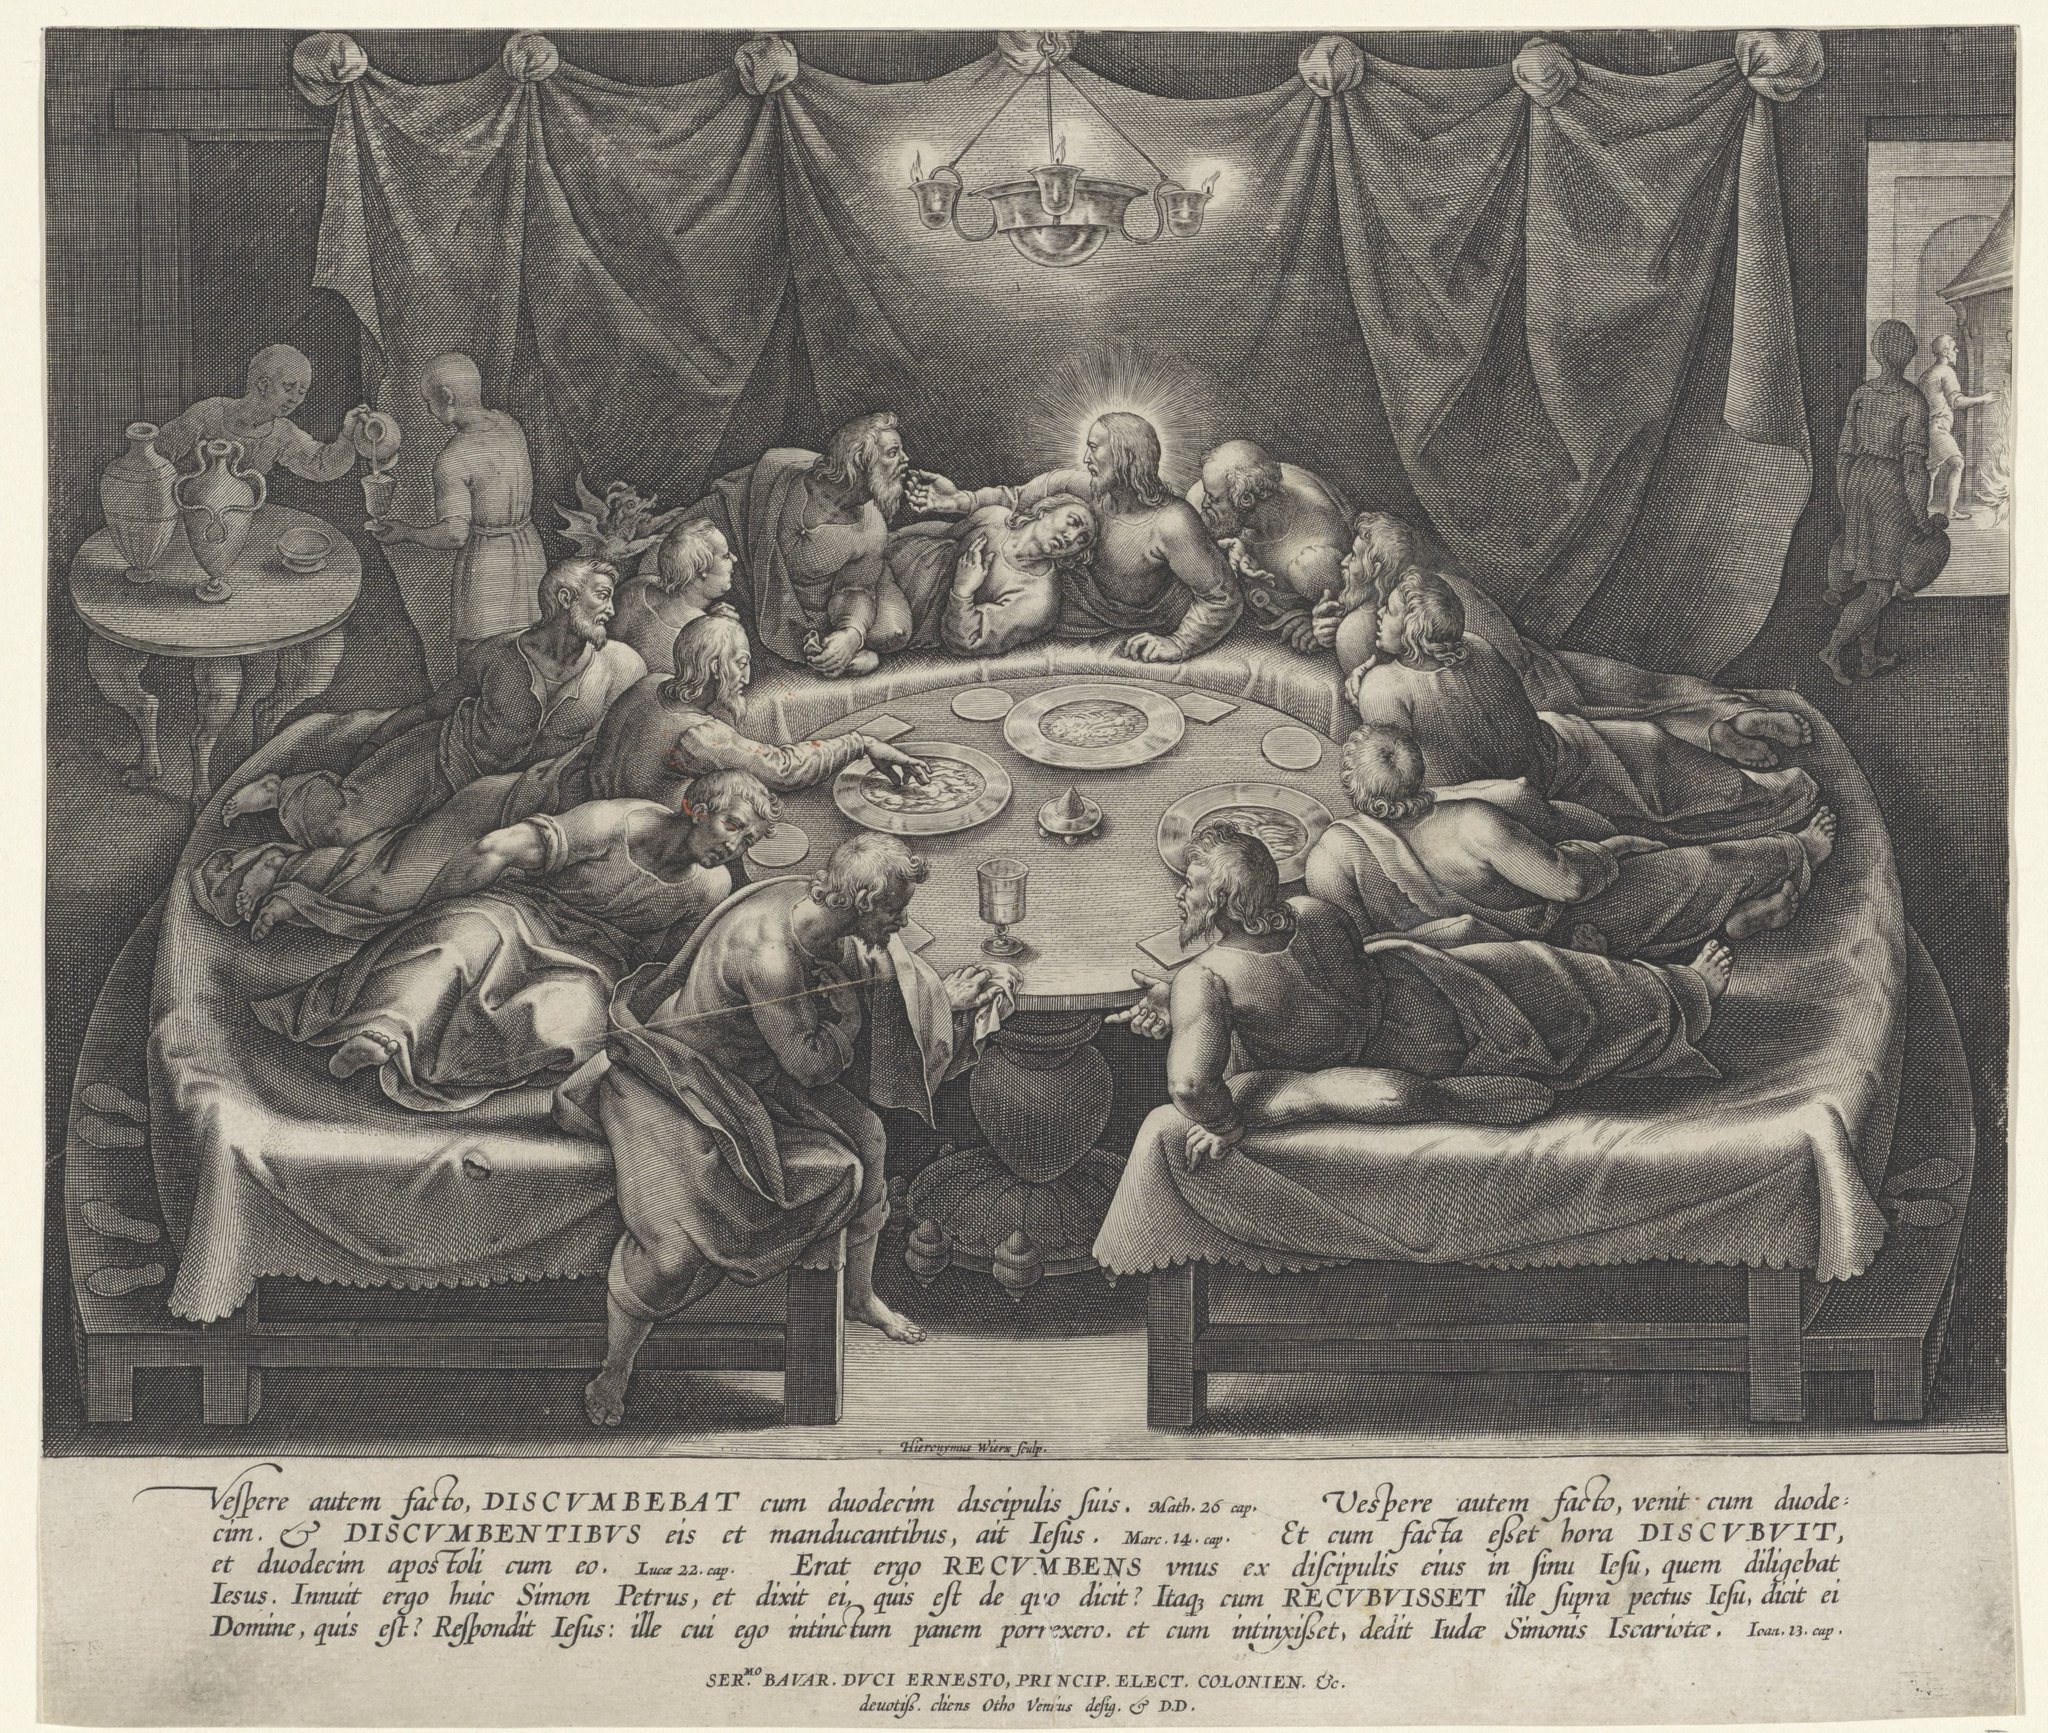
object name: print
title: Laatste Avondmaal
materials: paper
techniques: engraving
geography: antwerp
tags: last supper (in general) (matthew 26:21-35; mark 14:18-31; luke 22:3, 22:15-23; john 13:21-38)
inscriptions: collector's mark: Lugt 2228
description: Christus en de twaalf apostelen liggen rond een tafel. Johannes ligt dicht tegen Christus aan. Christus stopt eten in de mond van Judas (achter wiens rug een duiveltje tevoorschijn is gekomen). Onder de voorstelling Bijbelcitaten uit Mat. 26, Mar. 14, Luc. 22 en Joh. 13 in het Latijn. Daaronder een tweeregelig onderschrift met een opdracht in het Latijn.